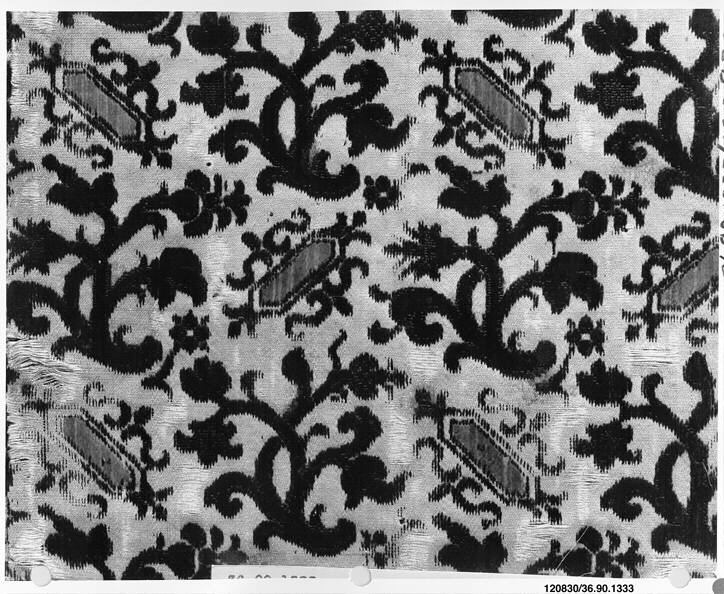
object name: piece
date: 1501-1700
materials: silk